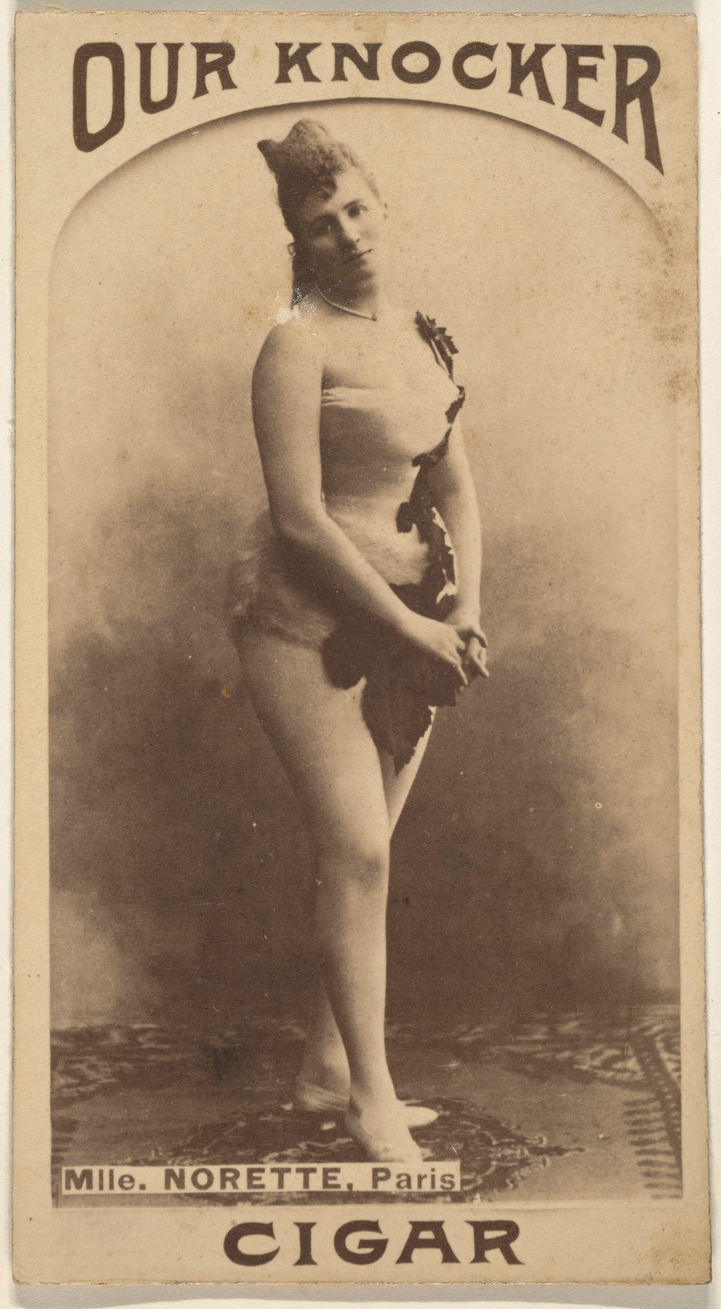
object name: photograph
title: Mlle. Norette, Paris, from the Actresses series (N665) promoting Our Knocker Cigars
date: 1888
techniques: albumen silver print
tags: portraits,women,actresses